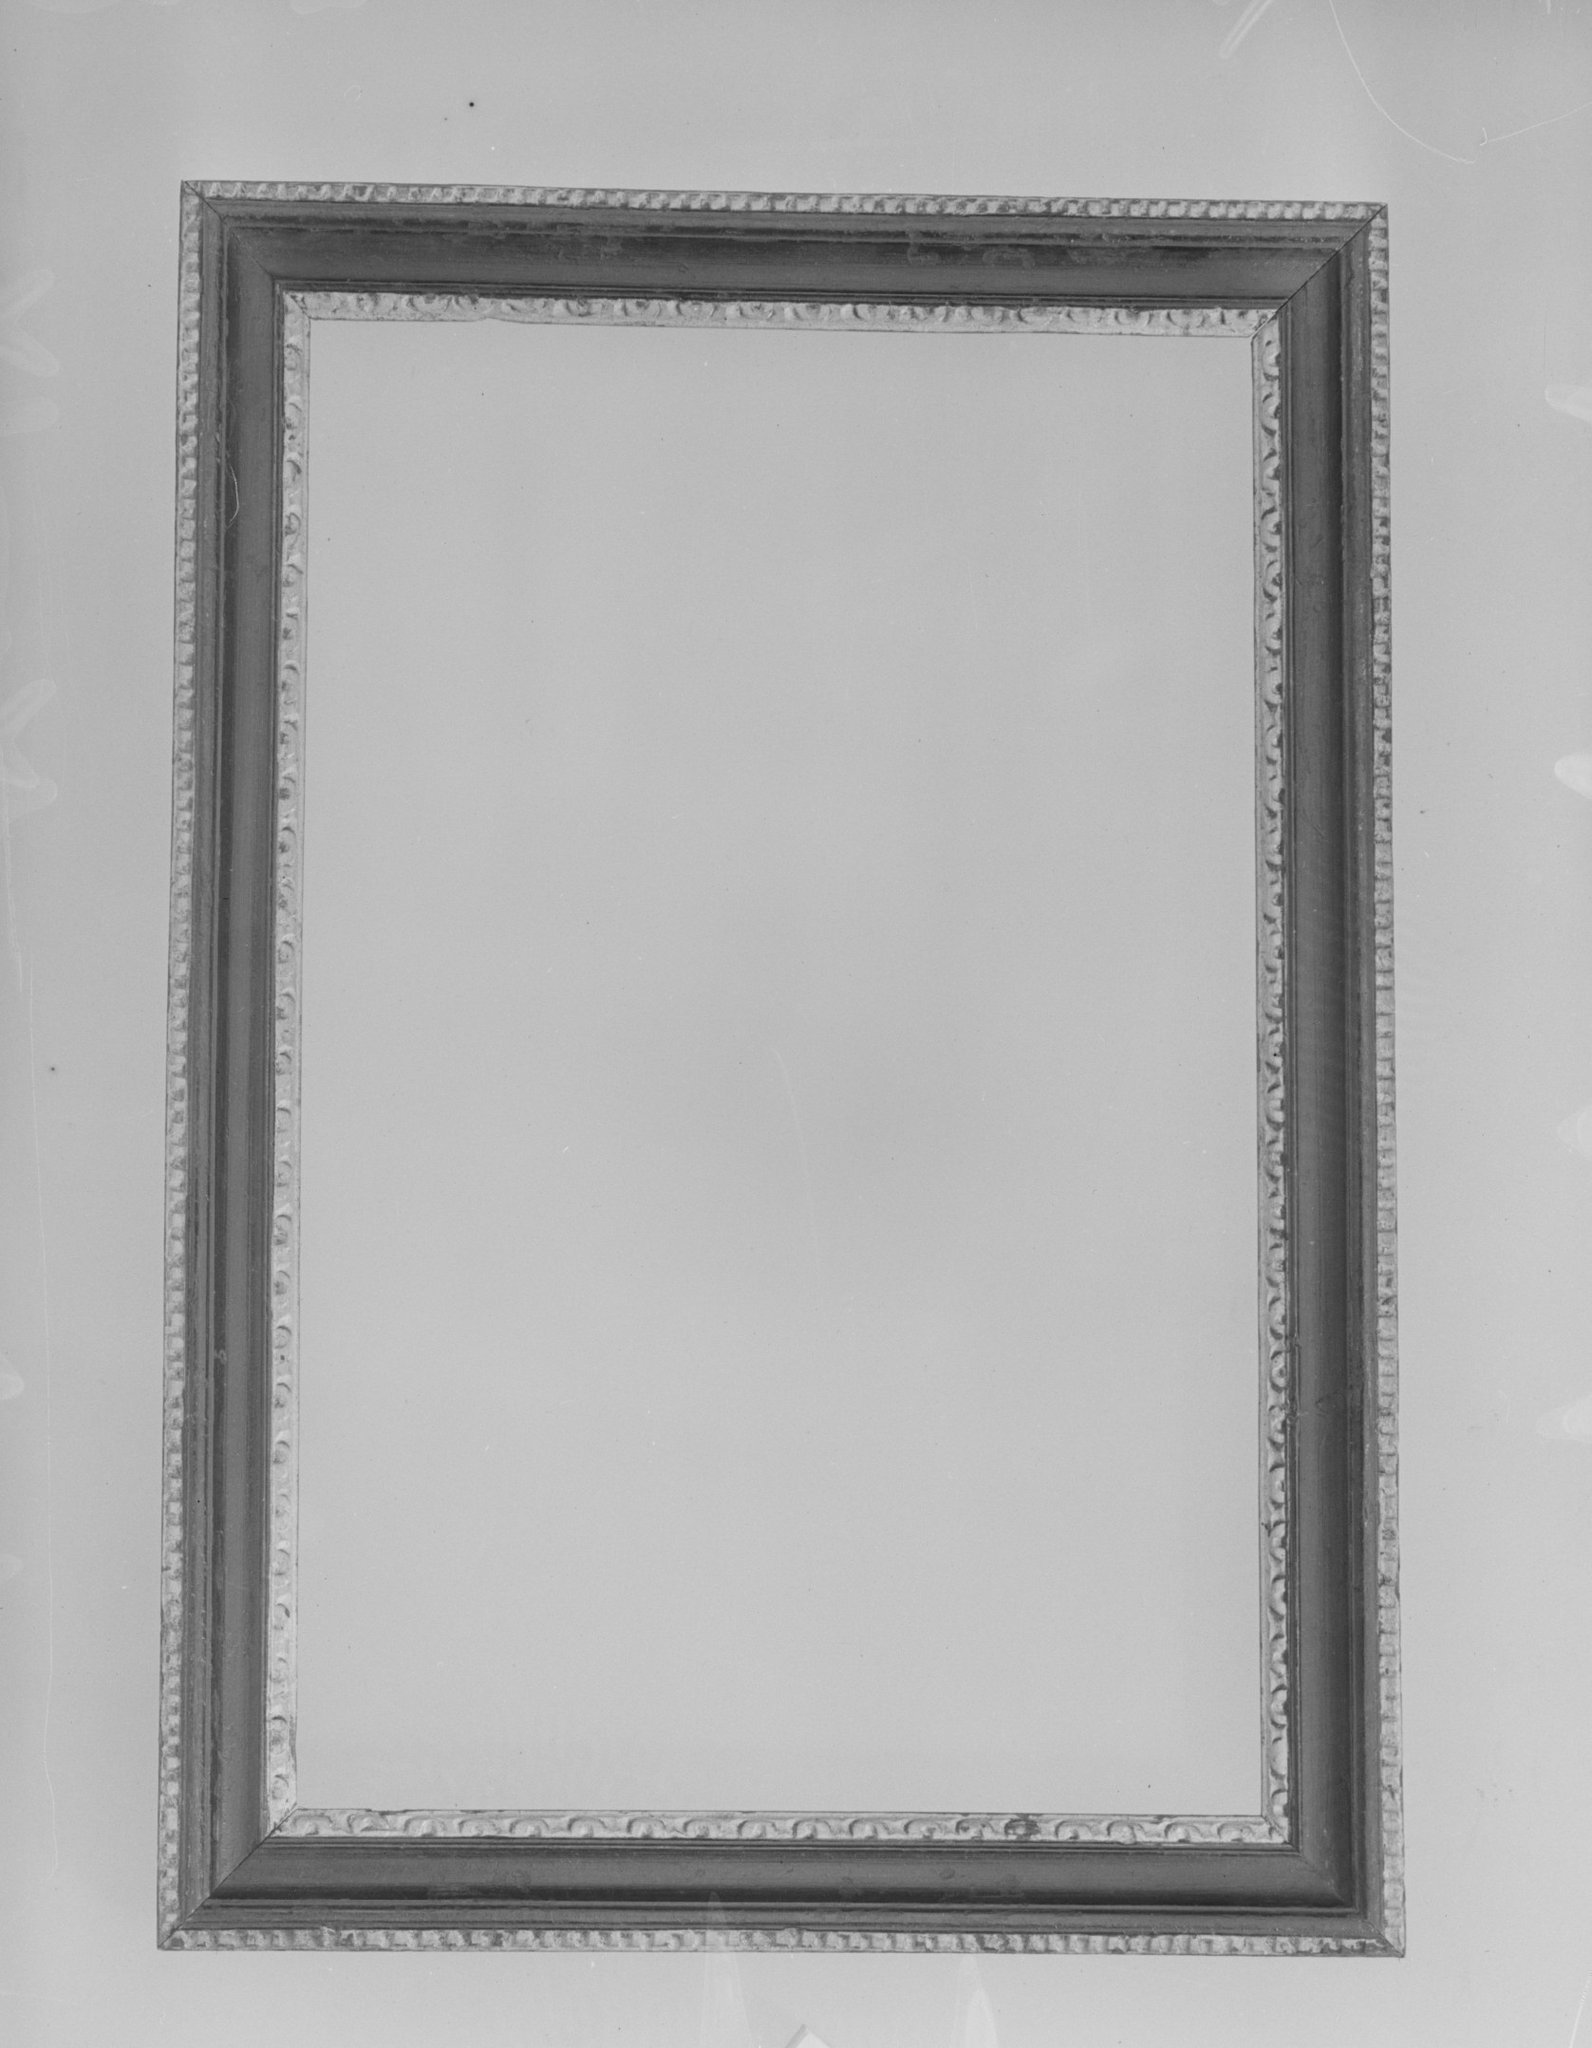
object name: frame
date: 1700-1800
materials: wood